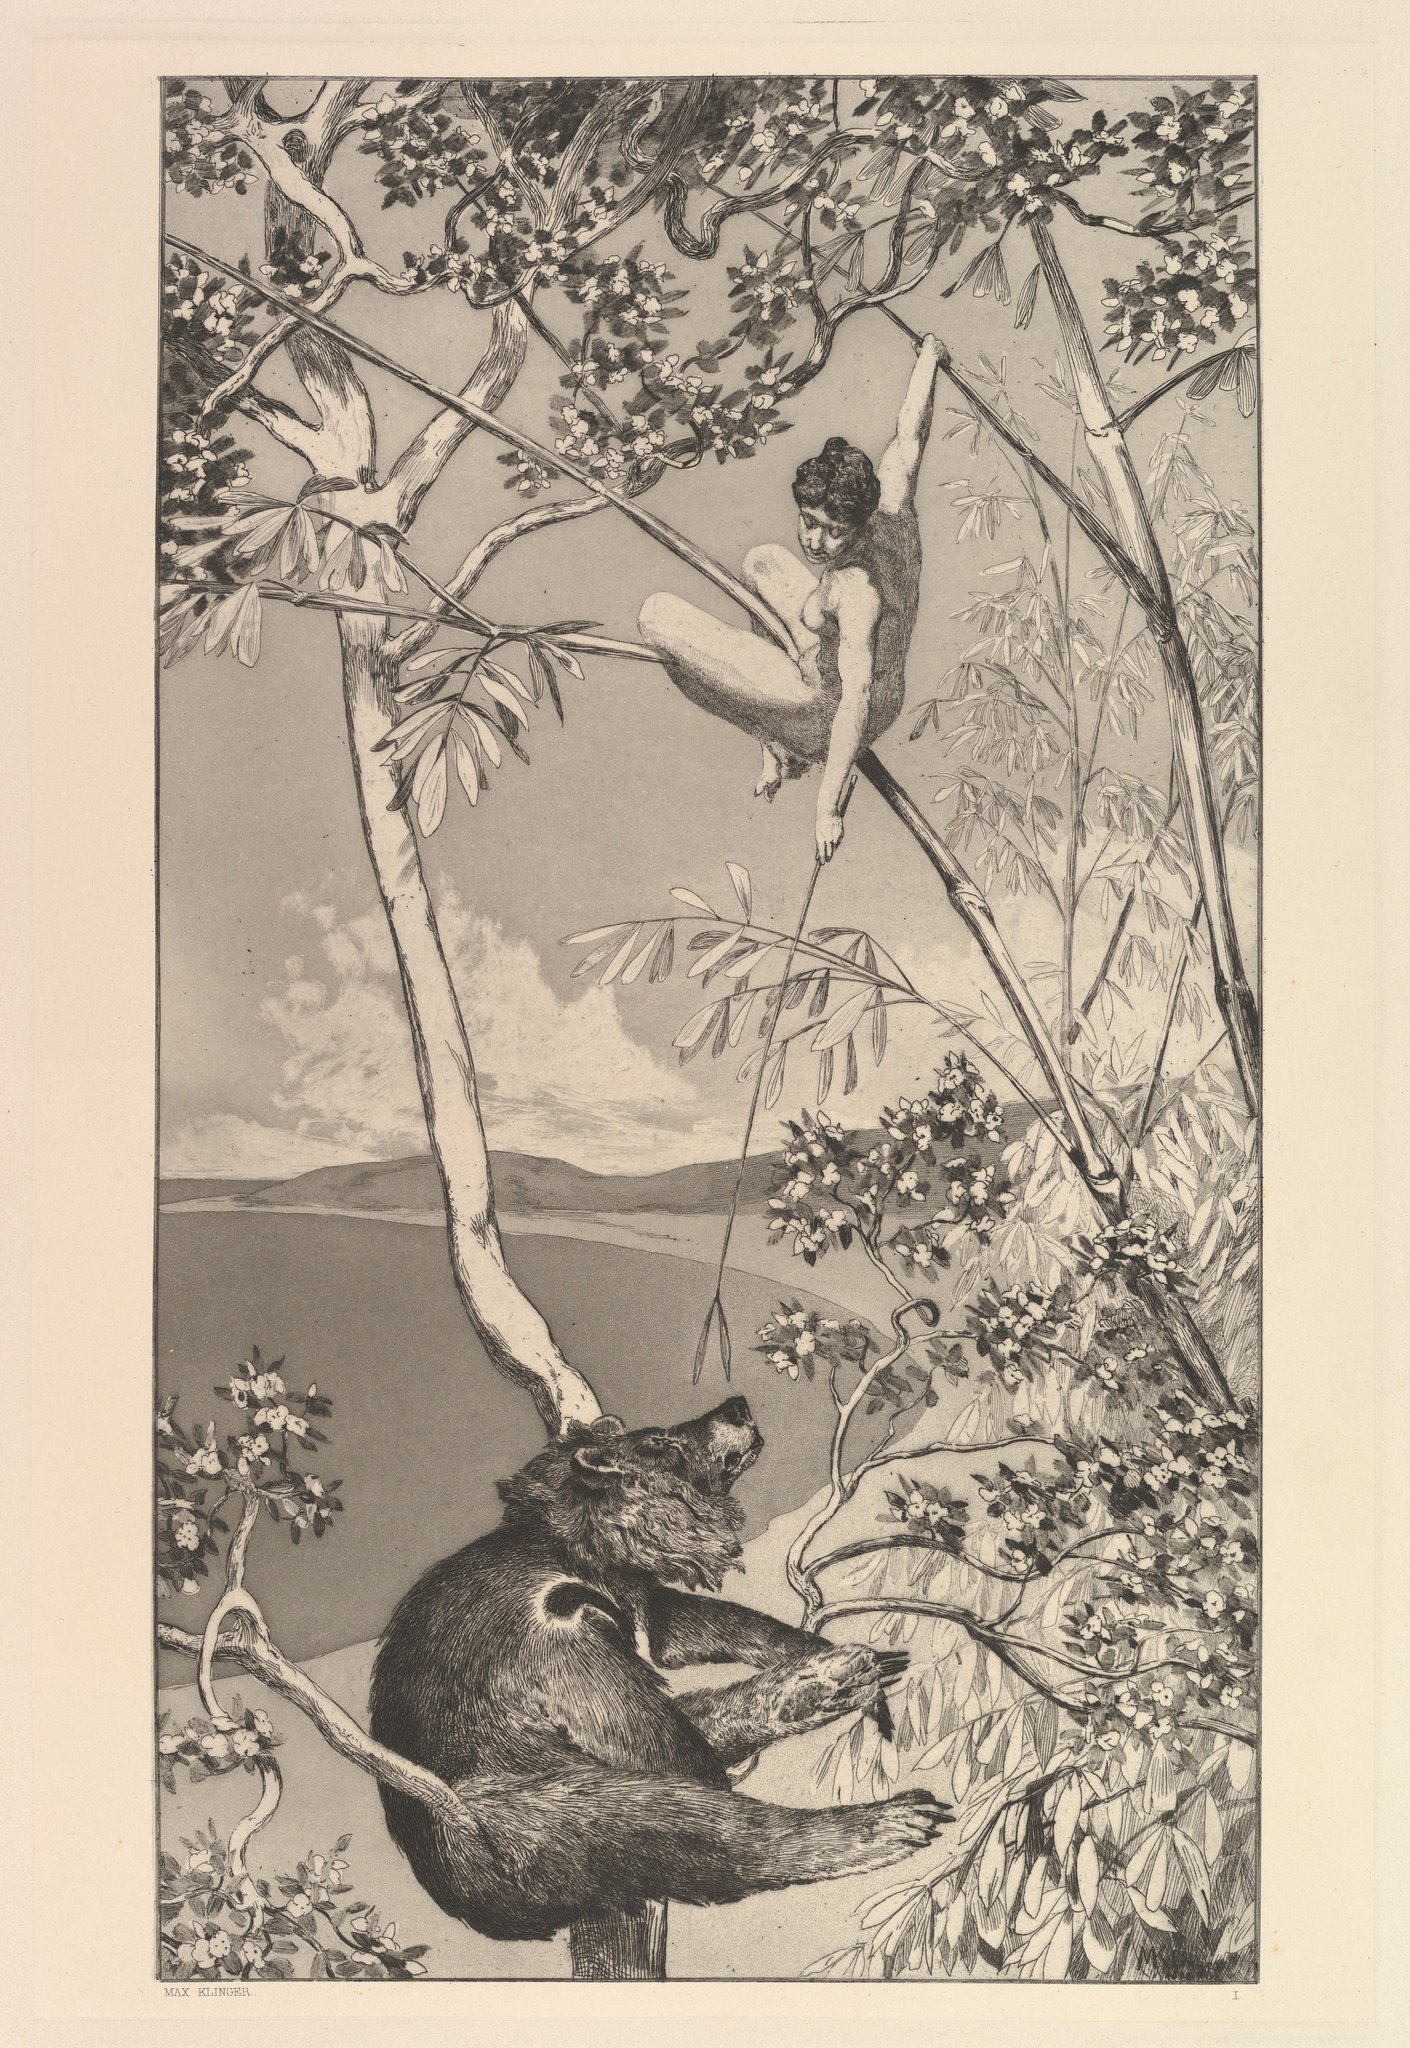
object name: portfolio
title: Intermezzi, Opus IV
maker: max klinger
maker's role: artist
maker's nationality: german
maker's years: 1857-1920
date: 1881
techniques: aquatint, etching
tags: bears,female nudes,mountains,leaves,trees